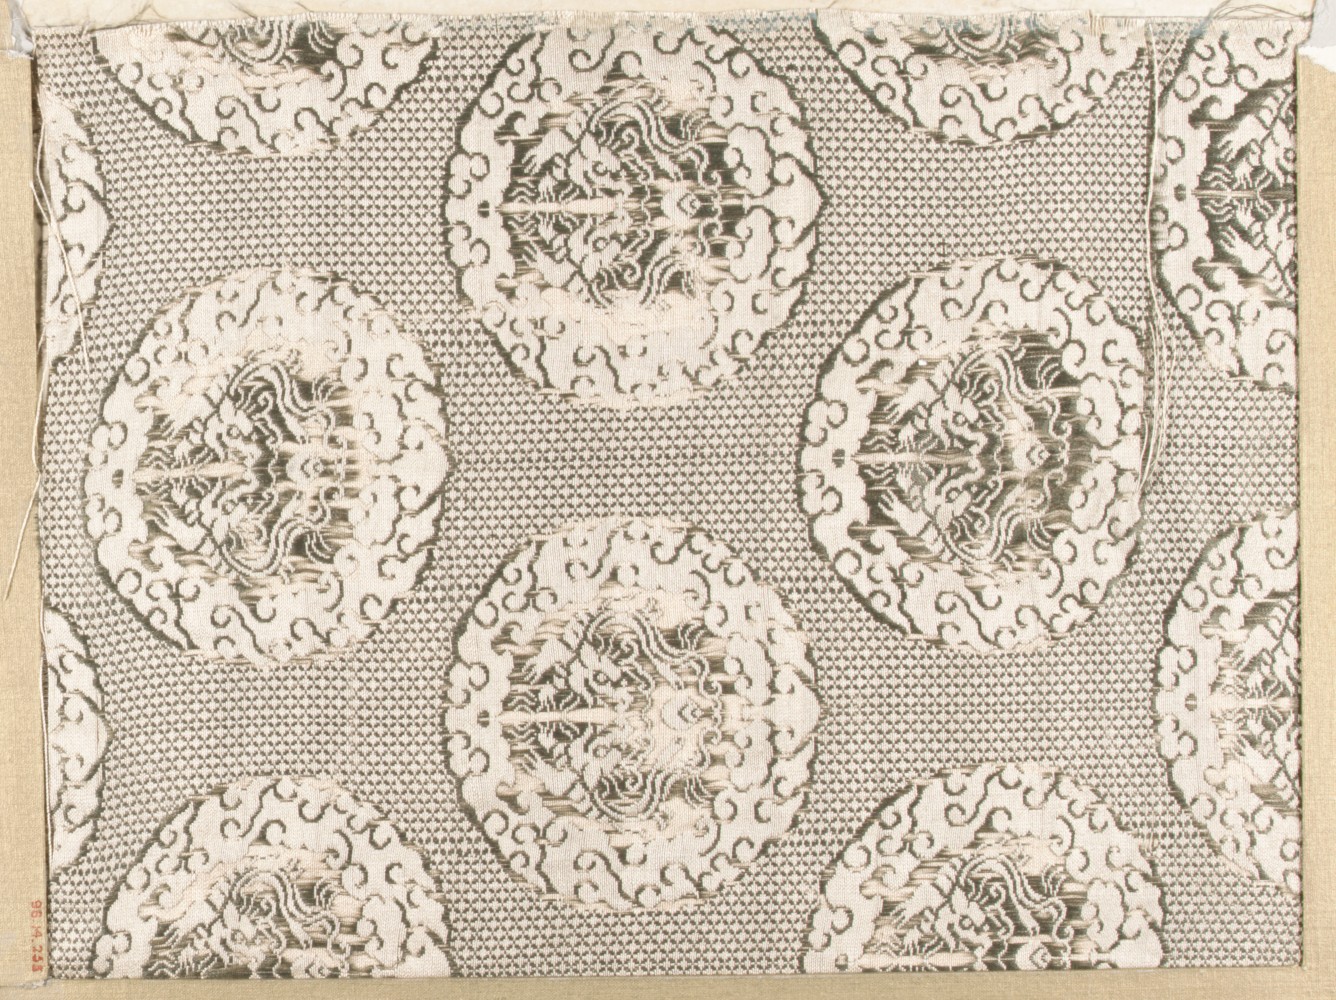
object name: piece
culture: japanese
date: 1701-1900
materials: silk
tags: dragons